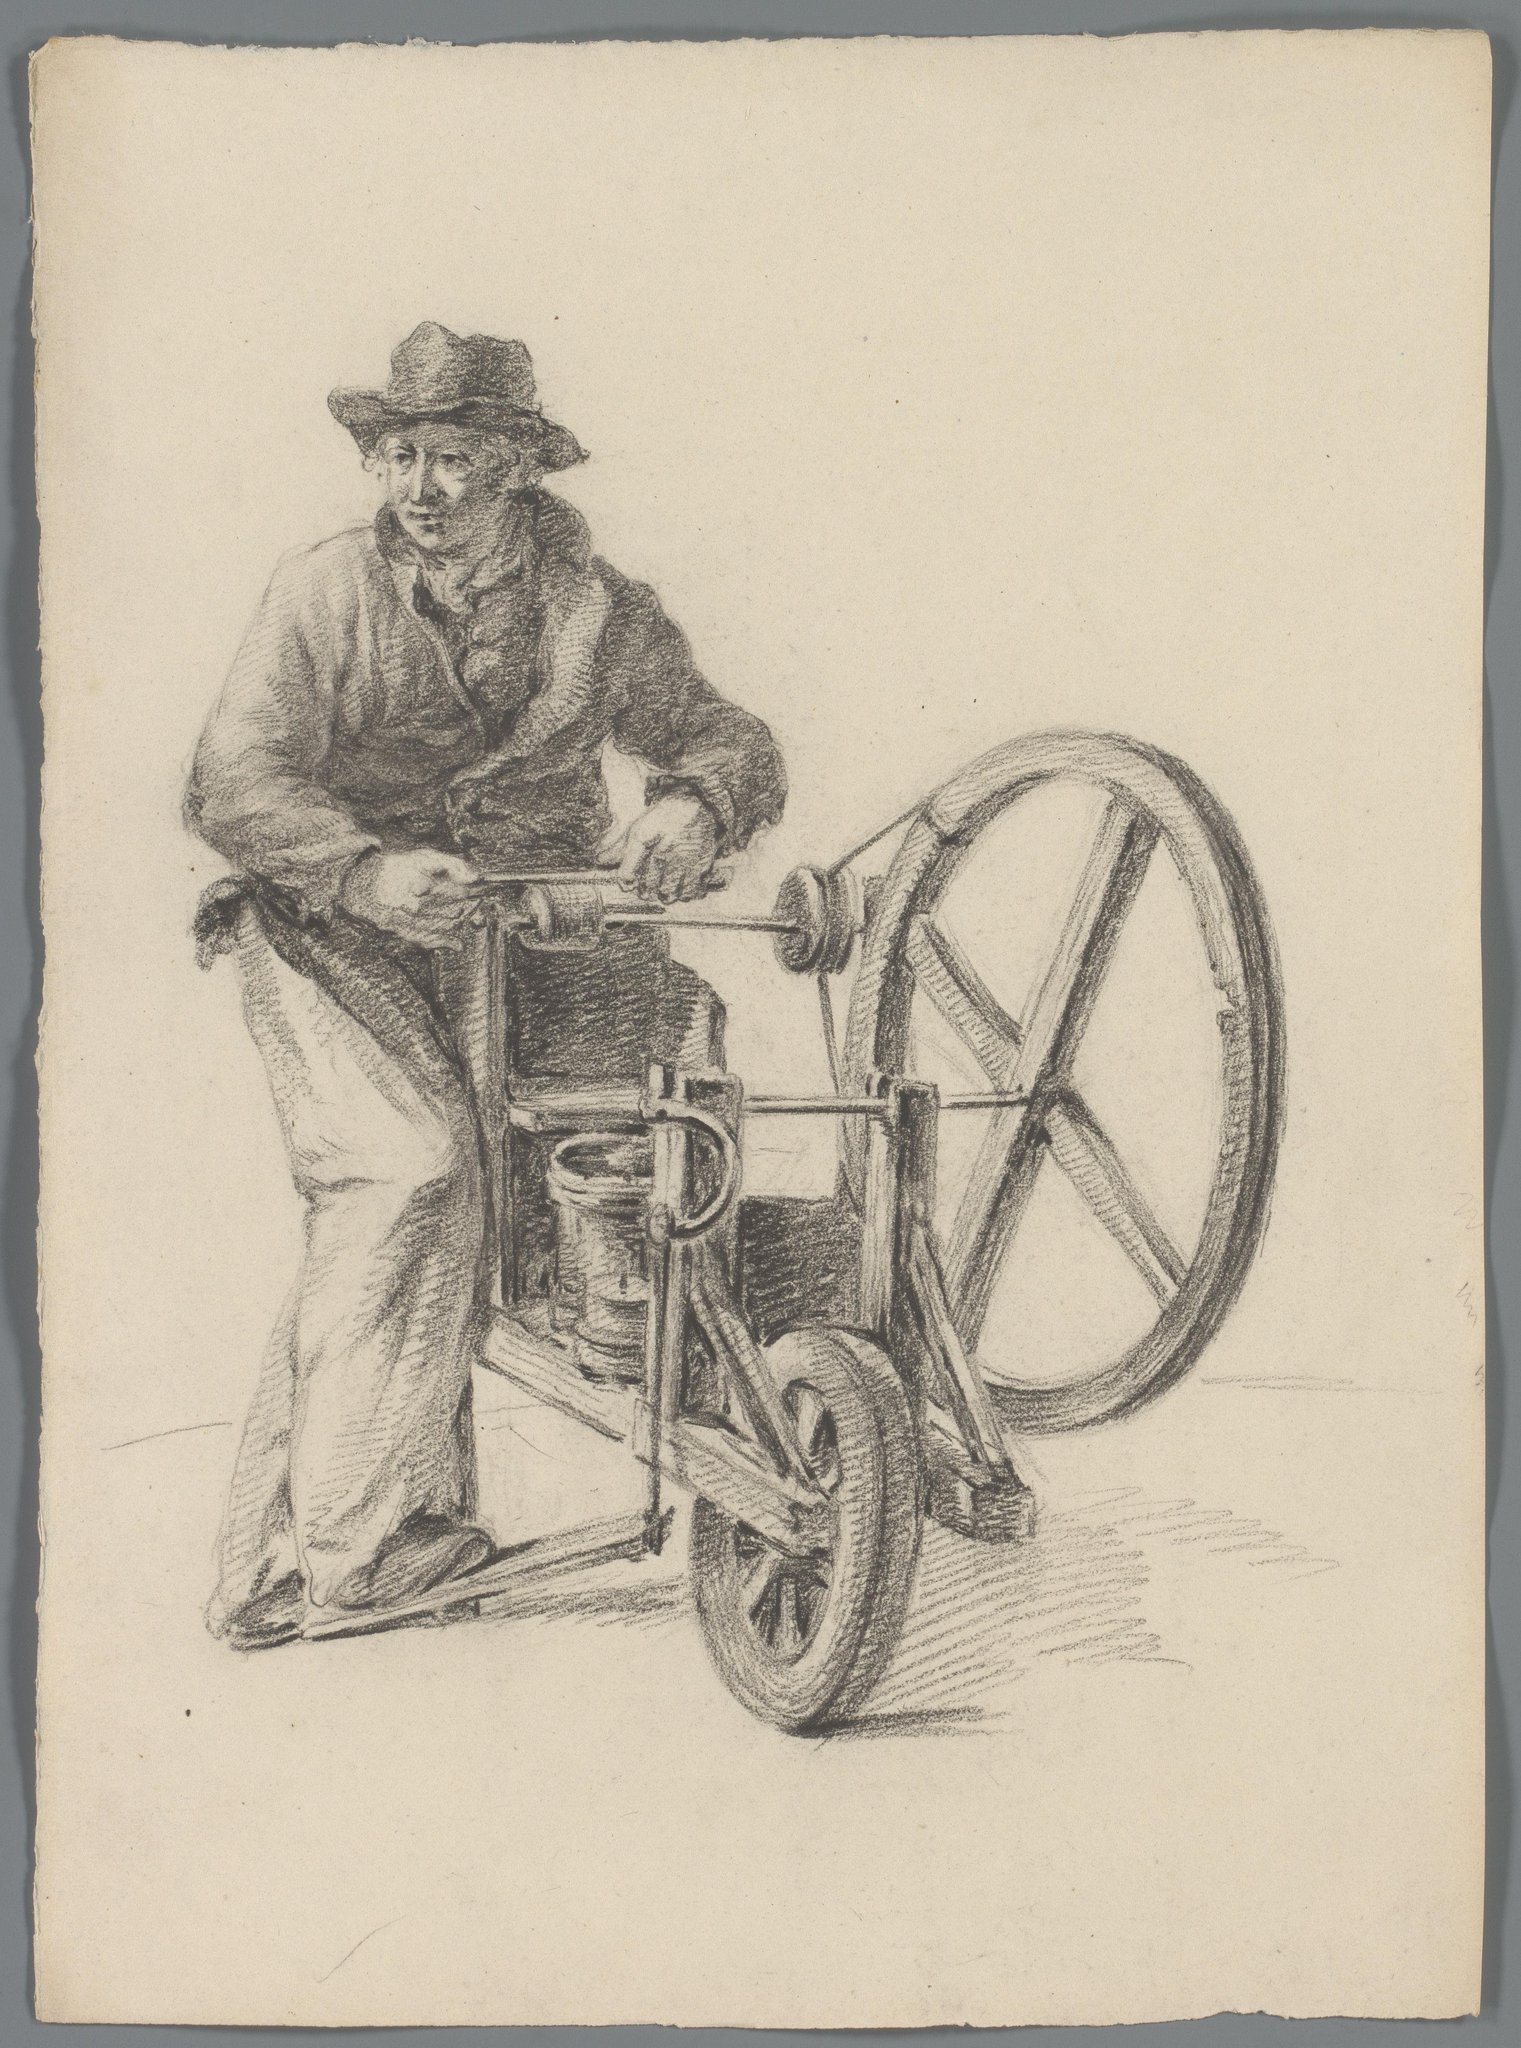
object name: drawing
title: Scharensliep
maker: Anonymous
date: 1820-1830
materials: chalk, paper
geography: the hague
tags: sharpening, grinding (industrial processes), adult man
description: Tekeningen waarschijnlijk ontstaan bij het Haagse kunstgenootschap ‘Tot Nut der Tekenkunst’, waar twee keer per week tekenavonden werden georganiseerd met geklede modellen.